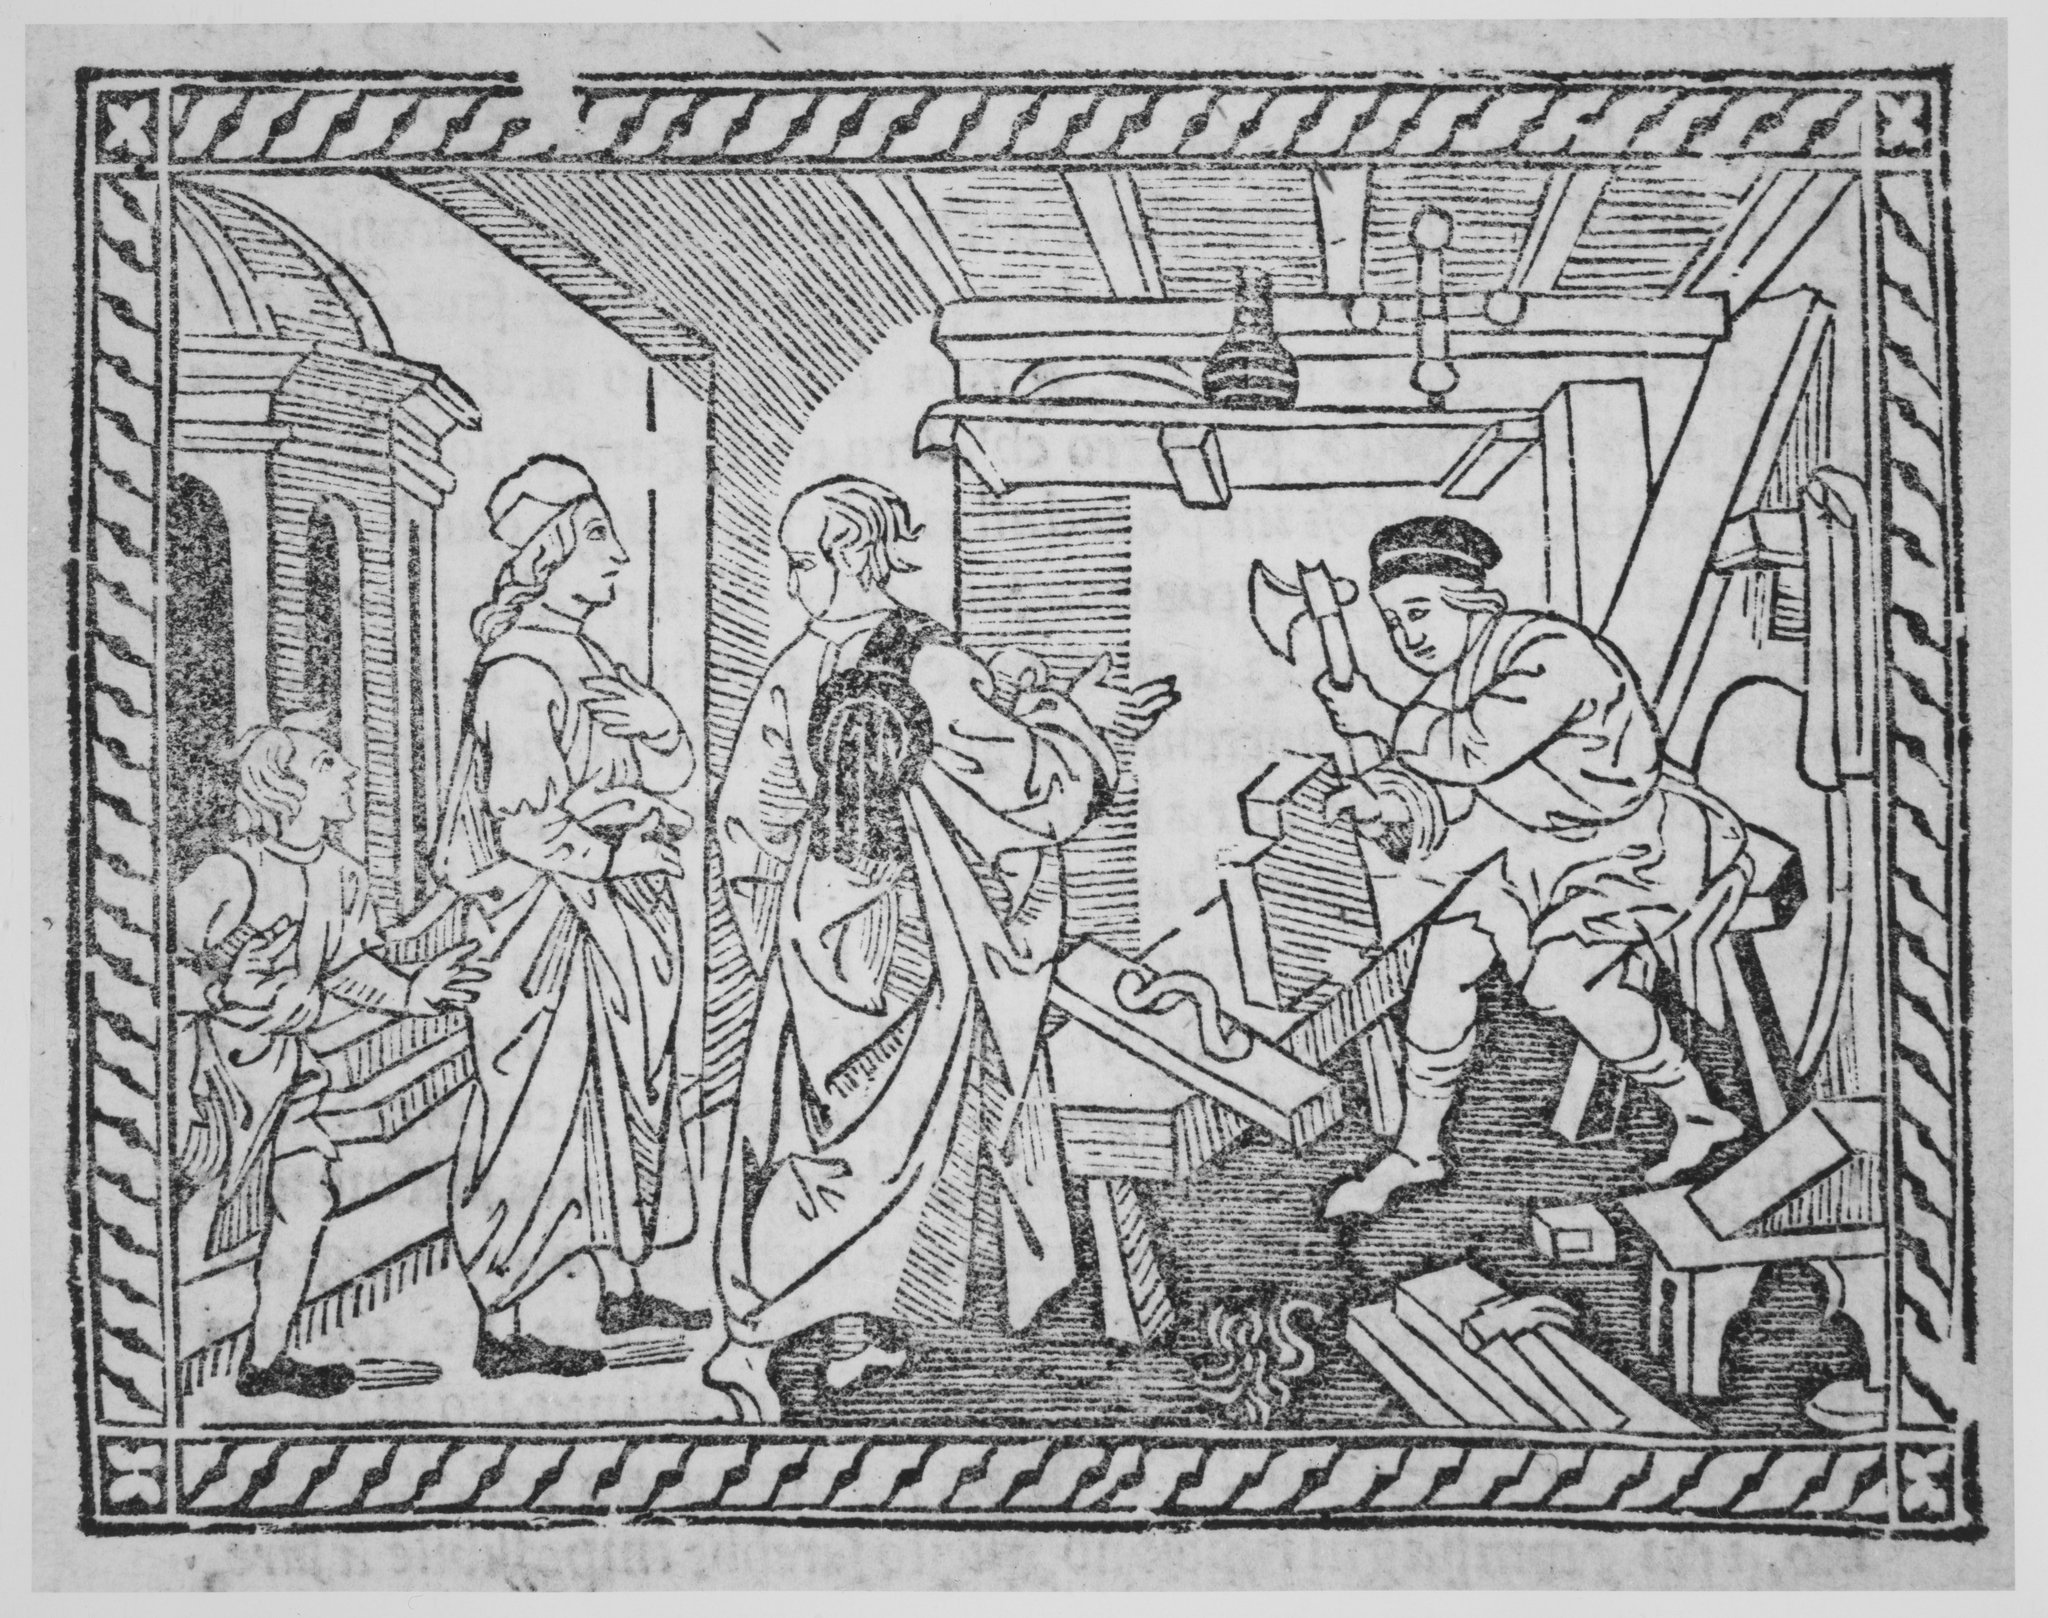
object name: book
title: Novella del Grasso Legnaiuolo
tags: children,men,working,axes